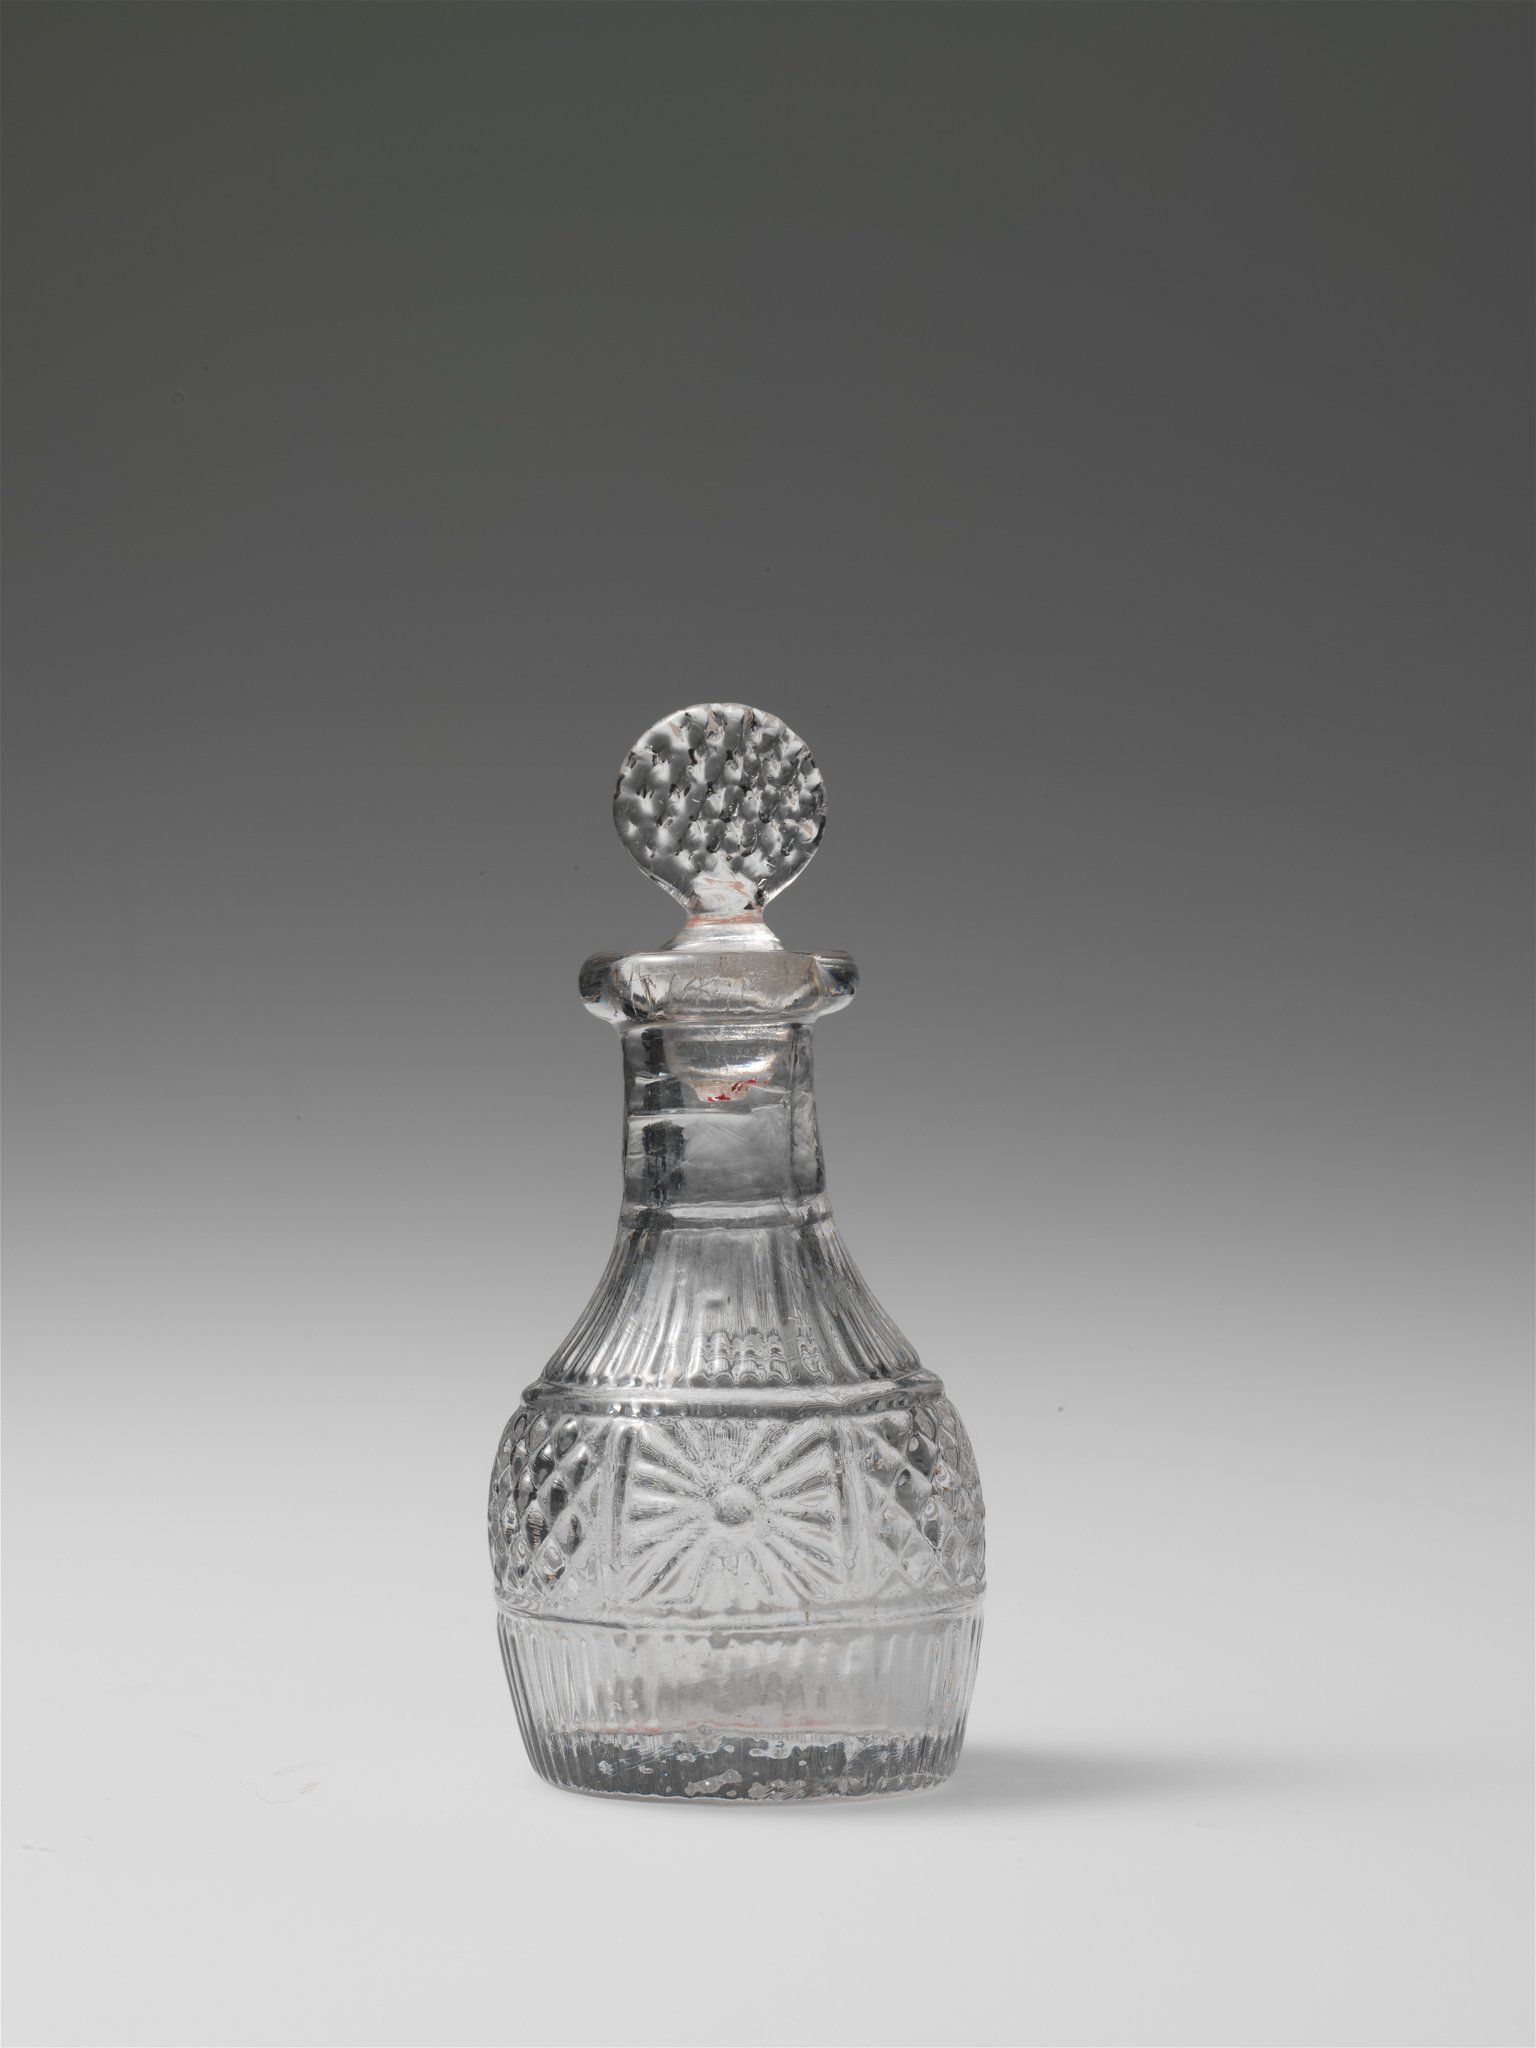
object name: toy decanter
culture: american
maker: boston & sandwich glass company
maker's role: maker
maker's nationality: american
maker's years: 1825-1888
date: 1825-1840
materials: glass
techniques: glassblowing, molding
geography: united states